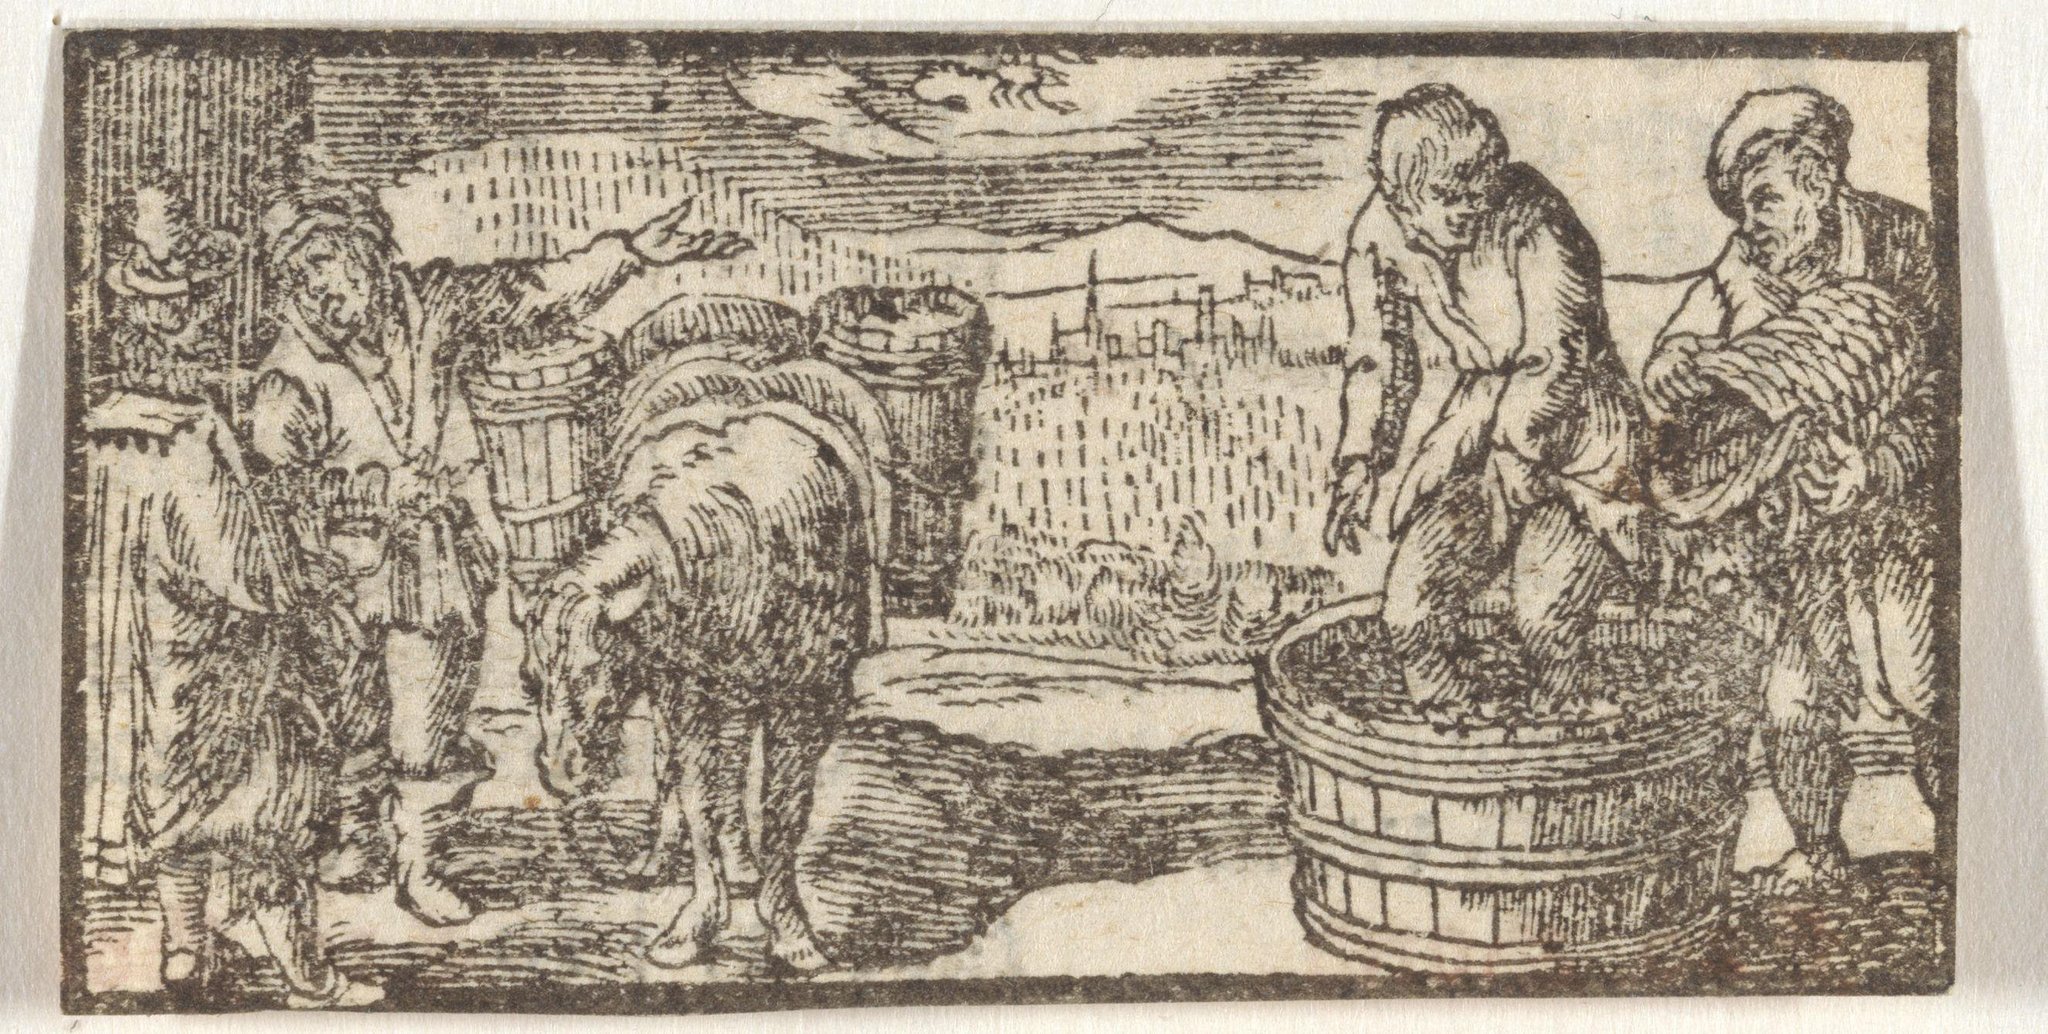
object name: book illustration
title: Oktober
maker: Anonymous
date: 1600-1699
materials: paper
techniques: letterpress printing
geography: netherlands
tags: pressing grapes, october and its 'labours' (+ with scorpio (october)), vintage, grape harvest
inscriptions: collector's mark: Lugt 2228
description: Een man staat in een grote ton druiven te persen naast een beladen ezel. Een andere man giet een mand met druiven leeg in de ton. Op de achtergrond liggen wijnbergen. Midden boven een schorpioen.